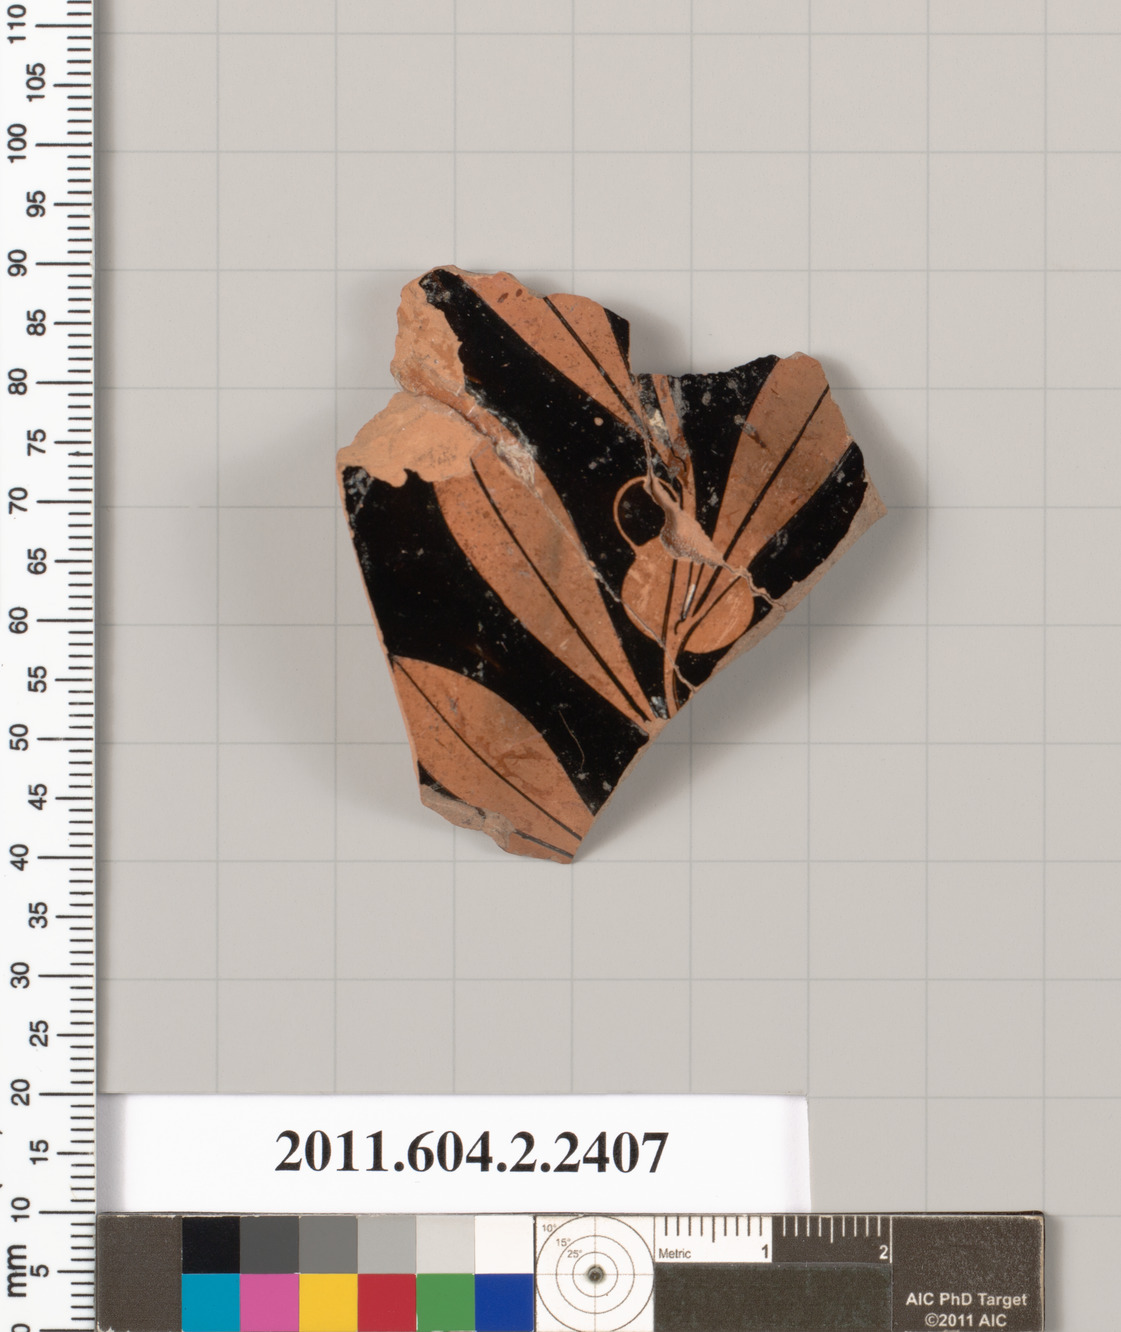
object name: rhyton fragment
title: Terracotta fragment of a rhyton (vase for libations or drinking)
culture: greek, attic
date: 470-460 BCE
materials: terracotta